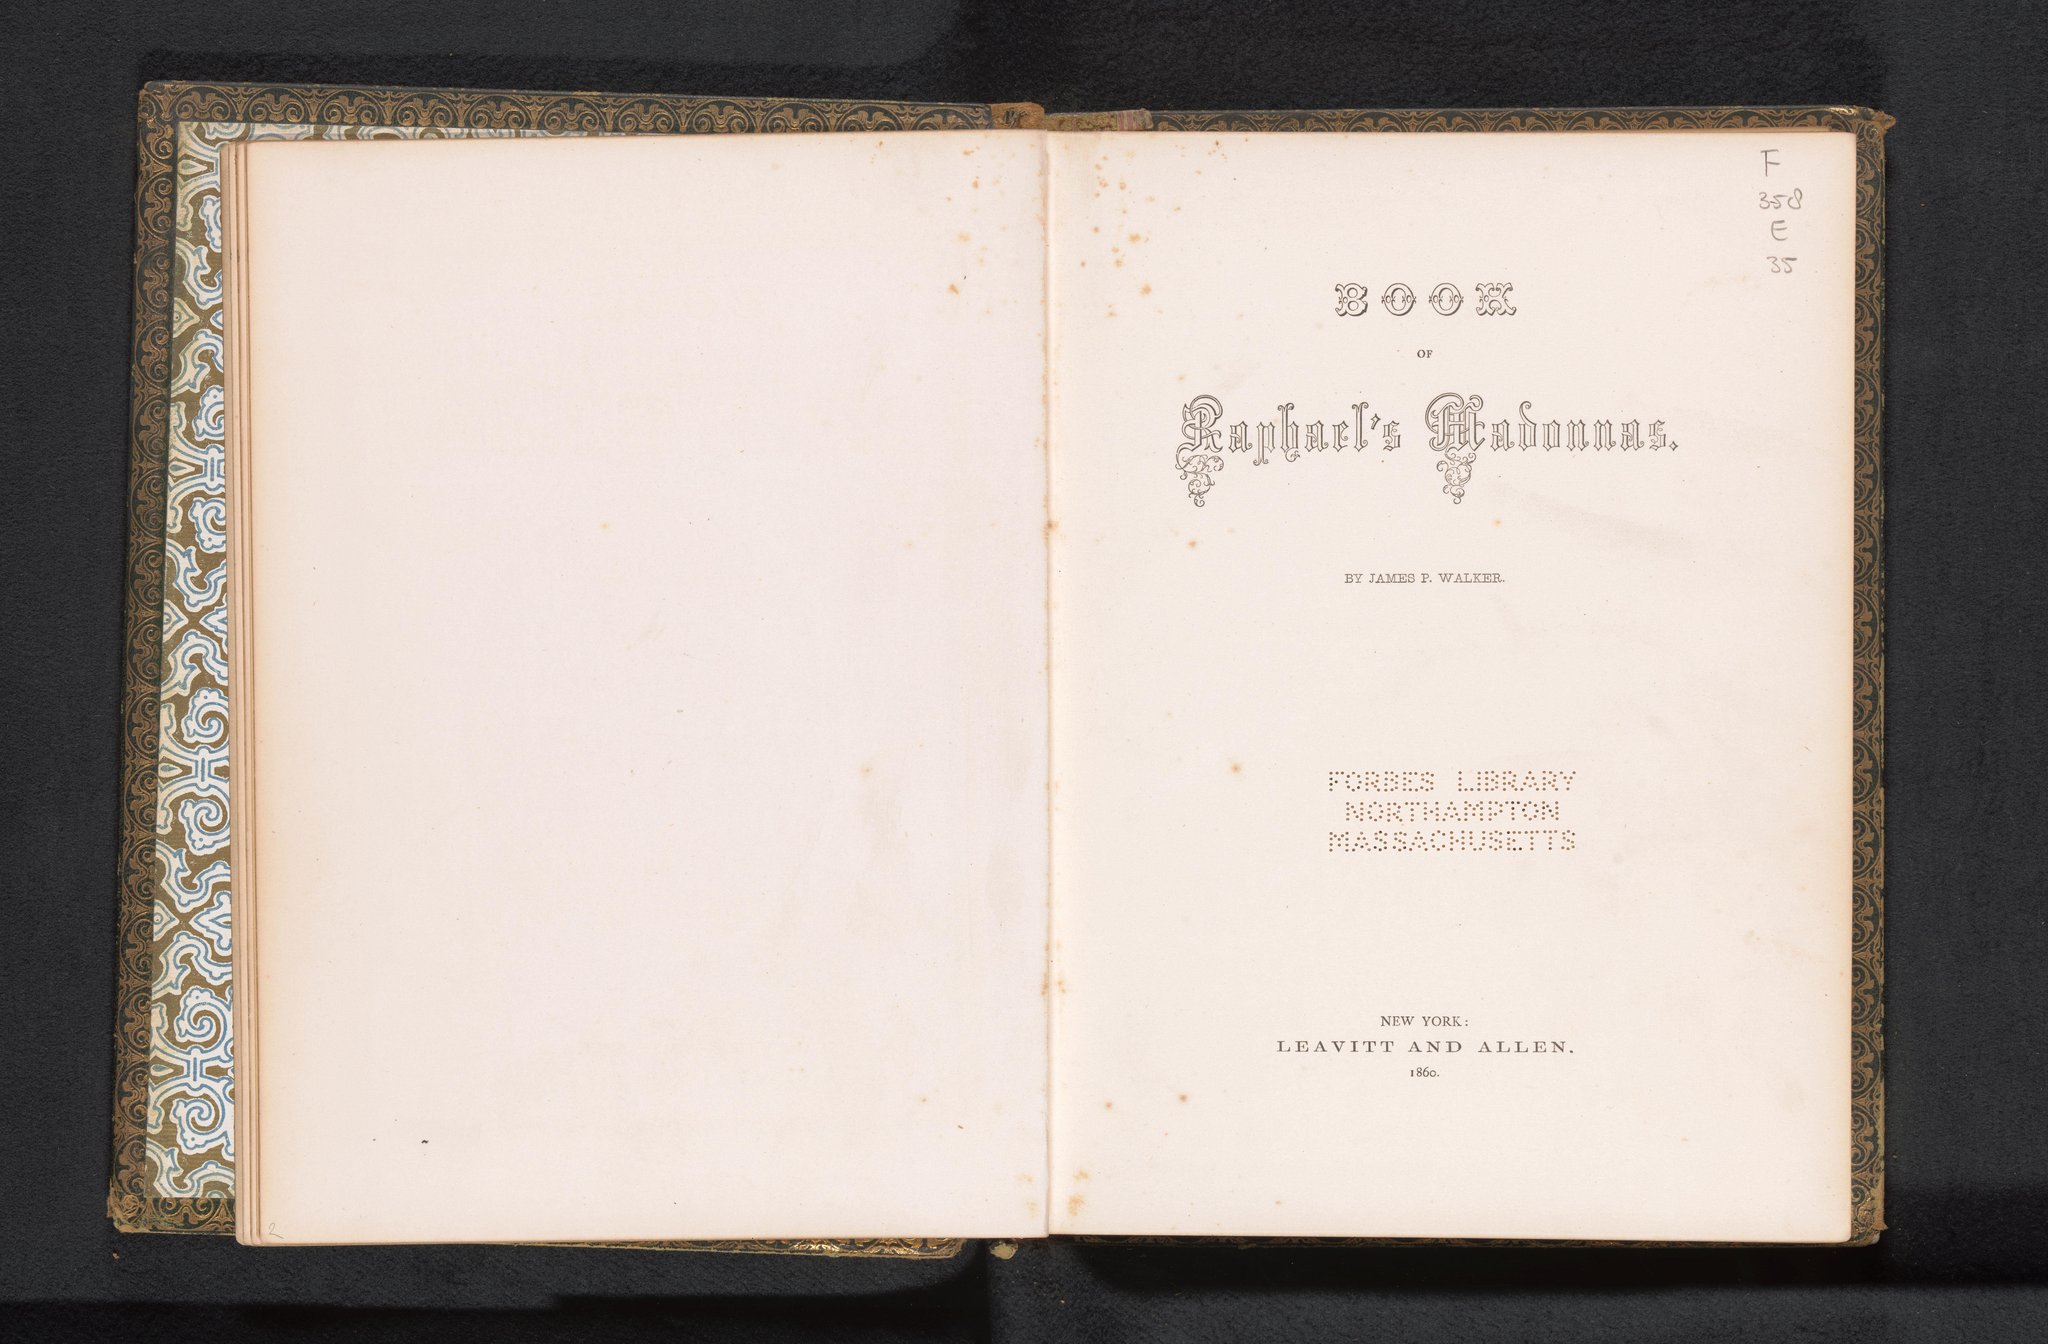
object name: book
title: Book of Raphael's madonnas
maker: james p. walker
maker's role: schrijver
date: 1860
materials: cardboard, leather, paper, photographic support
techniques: albumen print, printing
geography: new york city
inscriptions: inscription: ‘Forbes Library Northampton Mass’, inscription: ‘Forbes Library Northampton Mass’